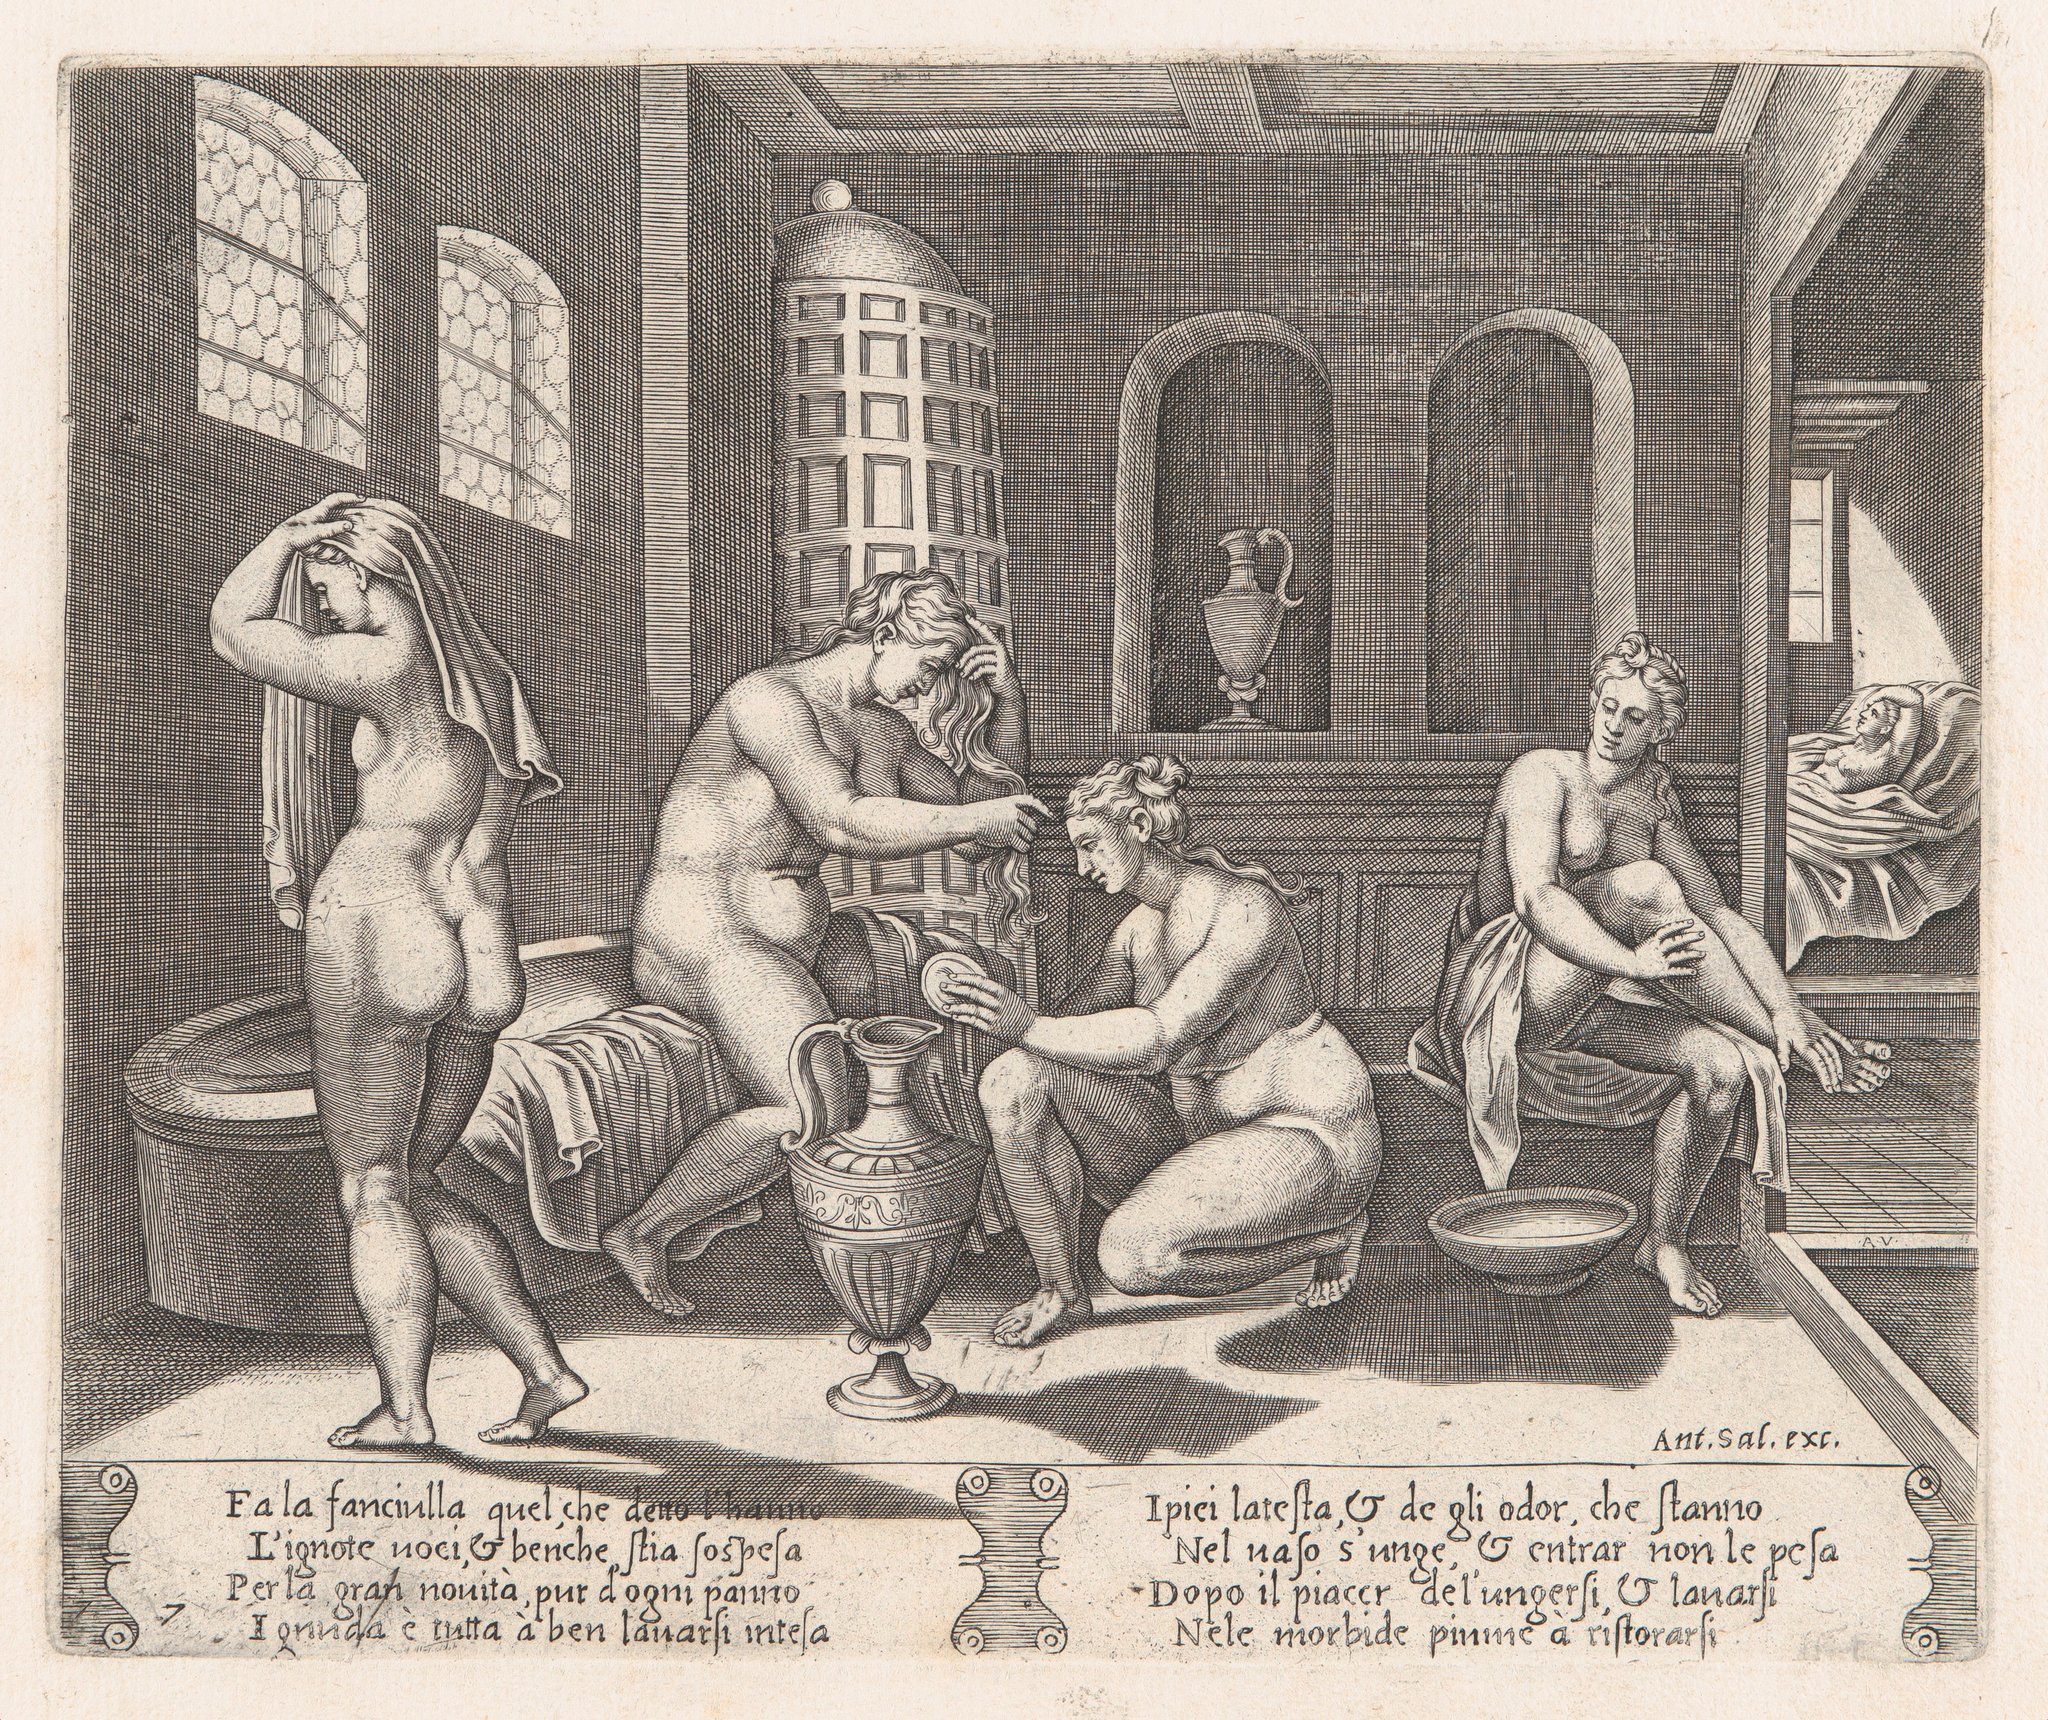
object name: print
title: Plate 7: Psyche attended in her bath, from "The Story of Cupid and Psyche as told by Apuleius"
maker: agostino veneziano (agostino dei musi)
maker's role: artist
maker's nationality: italian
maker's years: 1490-1536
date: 1530-1560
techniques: engraving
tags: psyche,bathing